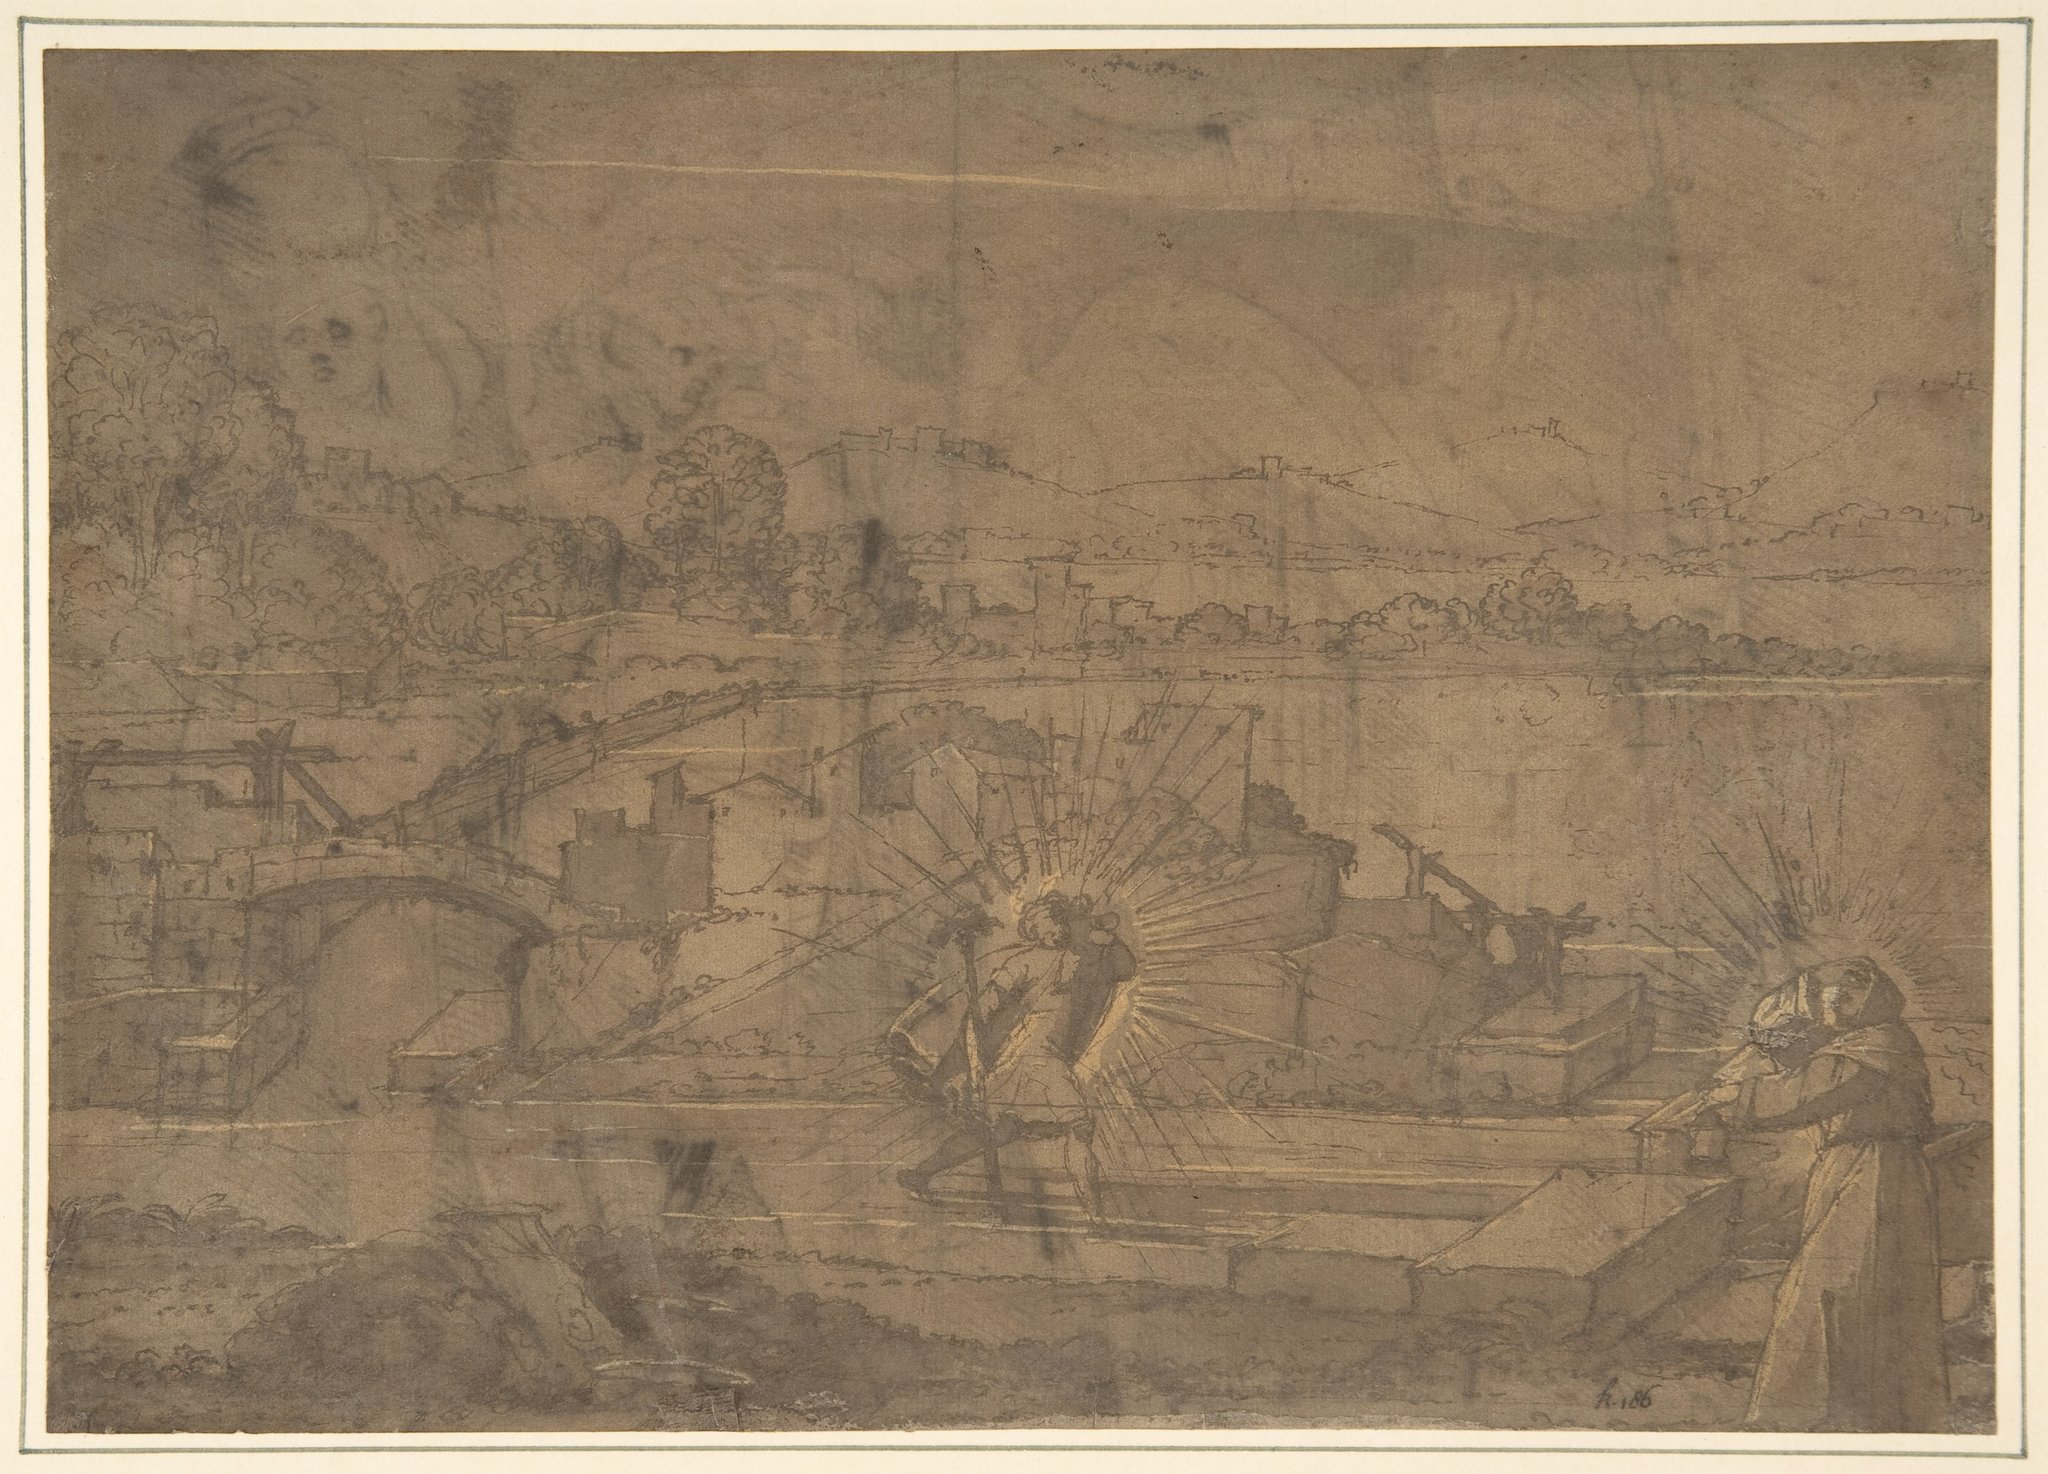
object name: drawing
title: Landscape with Saint Christopher and Male Monastic Saint (recto); Victory Crowning a Warrior, and Two Other Figures (verso)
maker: anonymous, italian, north italy, 16th century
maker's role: artist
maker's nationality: italian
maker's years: 1500-1600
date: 1501-1600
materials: gouache, ink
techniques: brush, highlighting, pen, wash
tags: landscapes,saint christopher